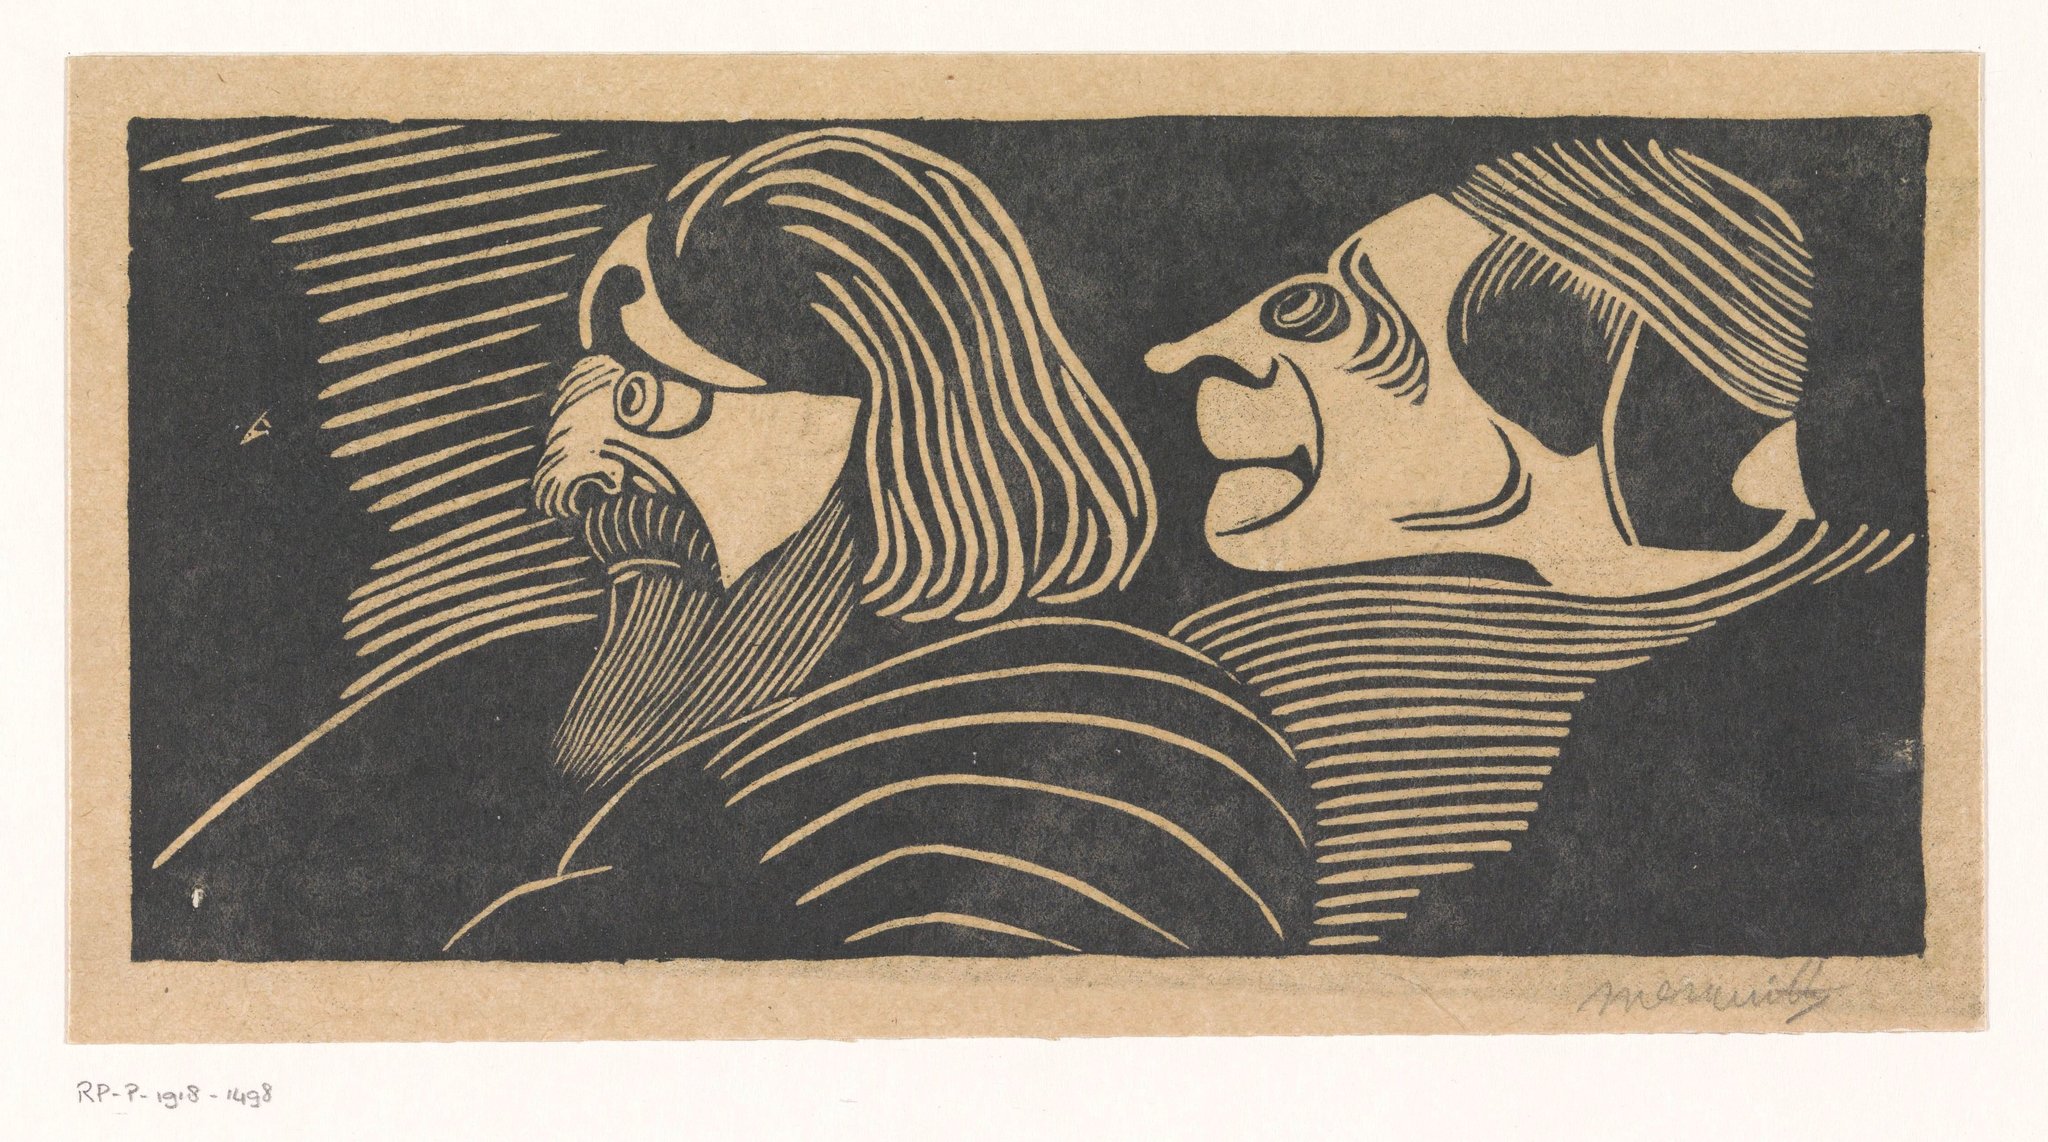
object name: print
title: Fantasie: twee mannenkoppen in profiel naar links, links een zwart profiel in tegengestelde richting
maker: samuel jessurun de mesquita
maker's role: draughtsman, print maker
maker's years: 1868-1944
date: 1918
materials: paper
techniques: woodcut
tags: adult man, head-gear: hat, beard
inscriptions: collector's mark: Lugt 2228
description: De rechter man draagt een muts; de linker man heeft een baard.